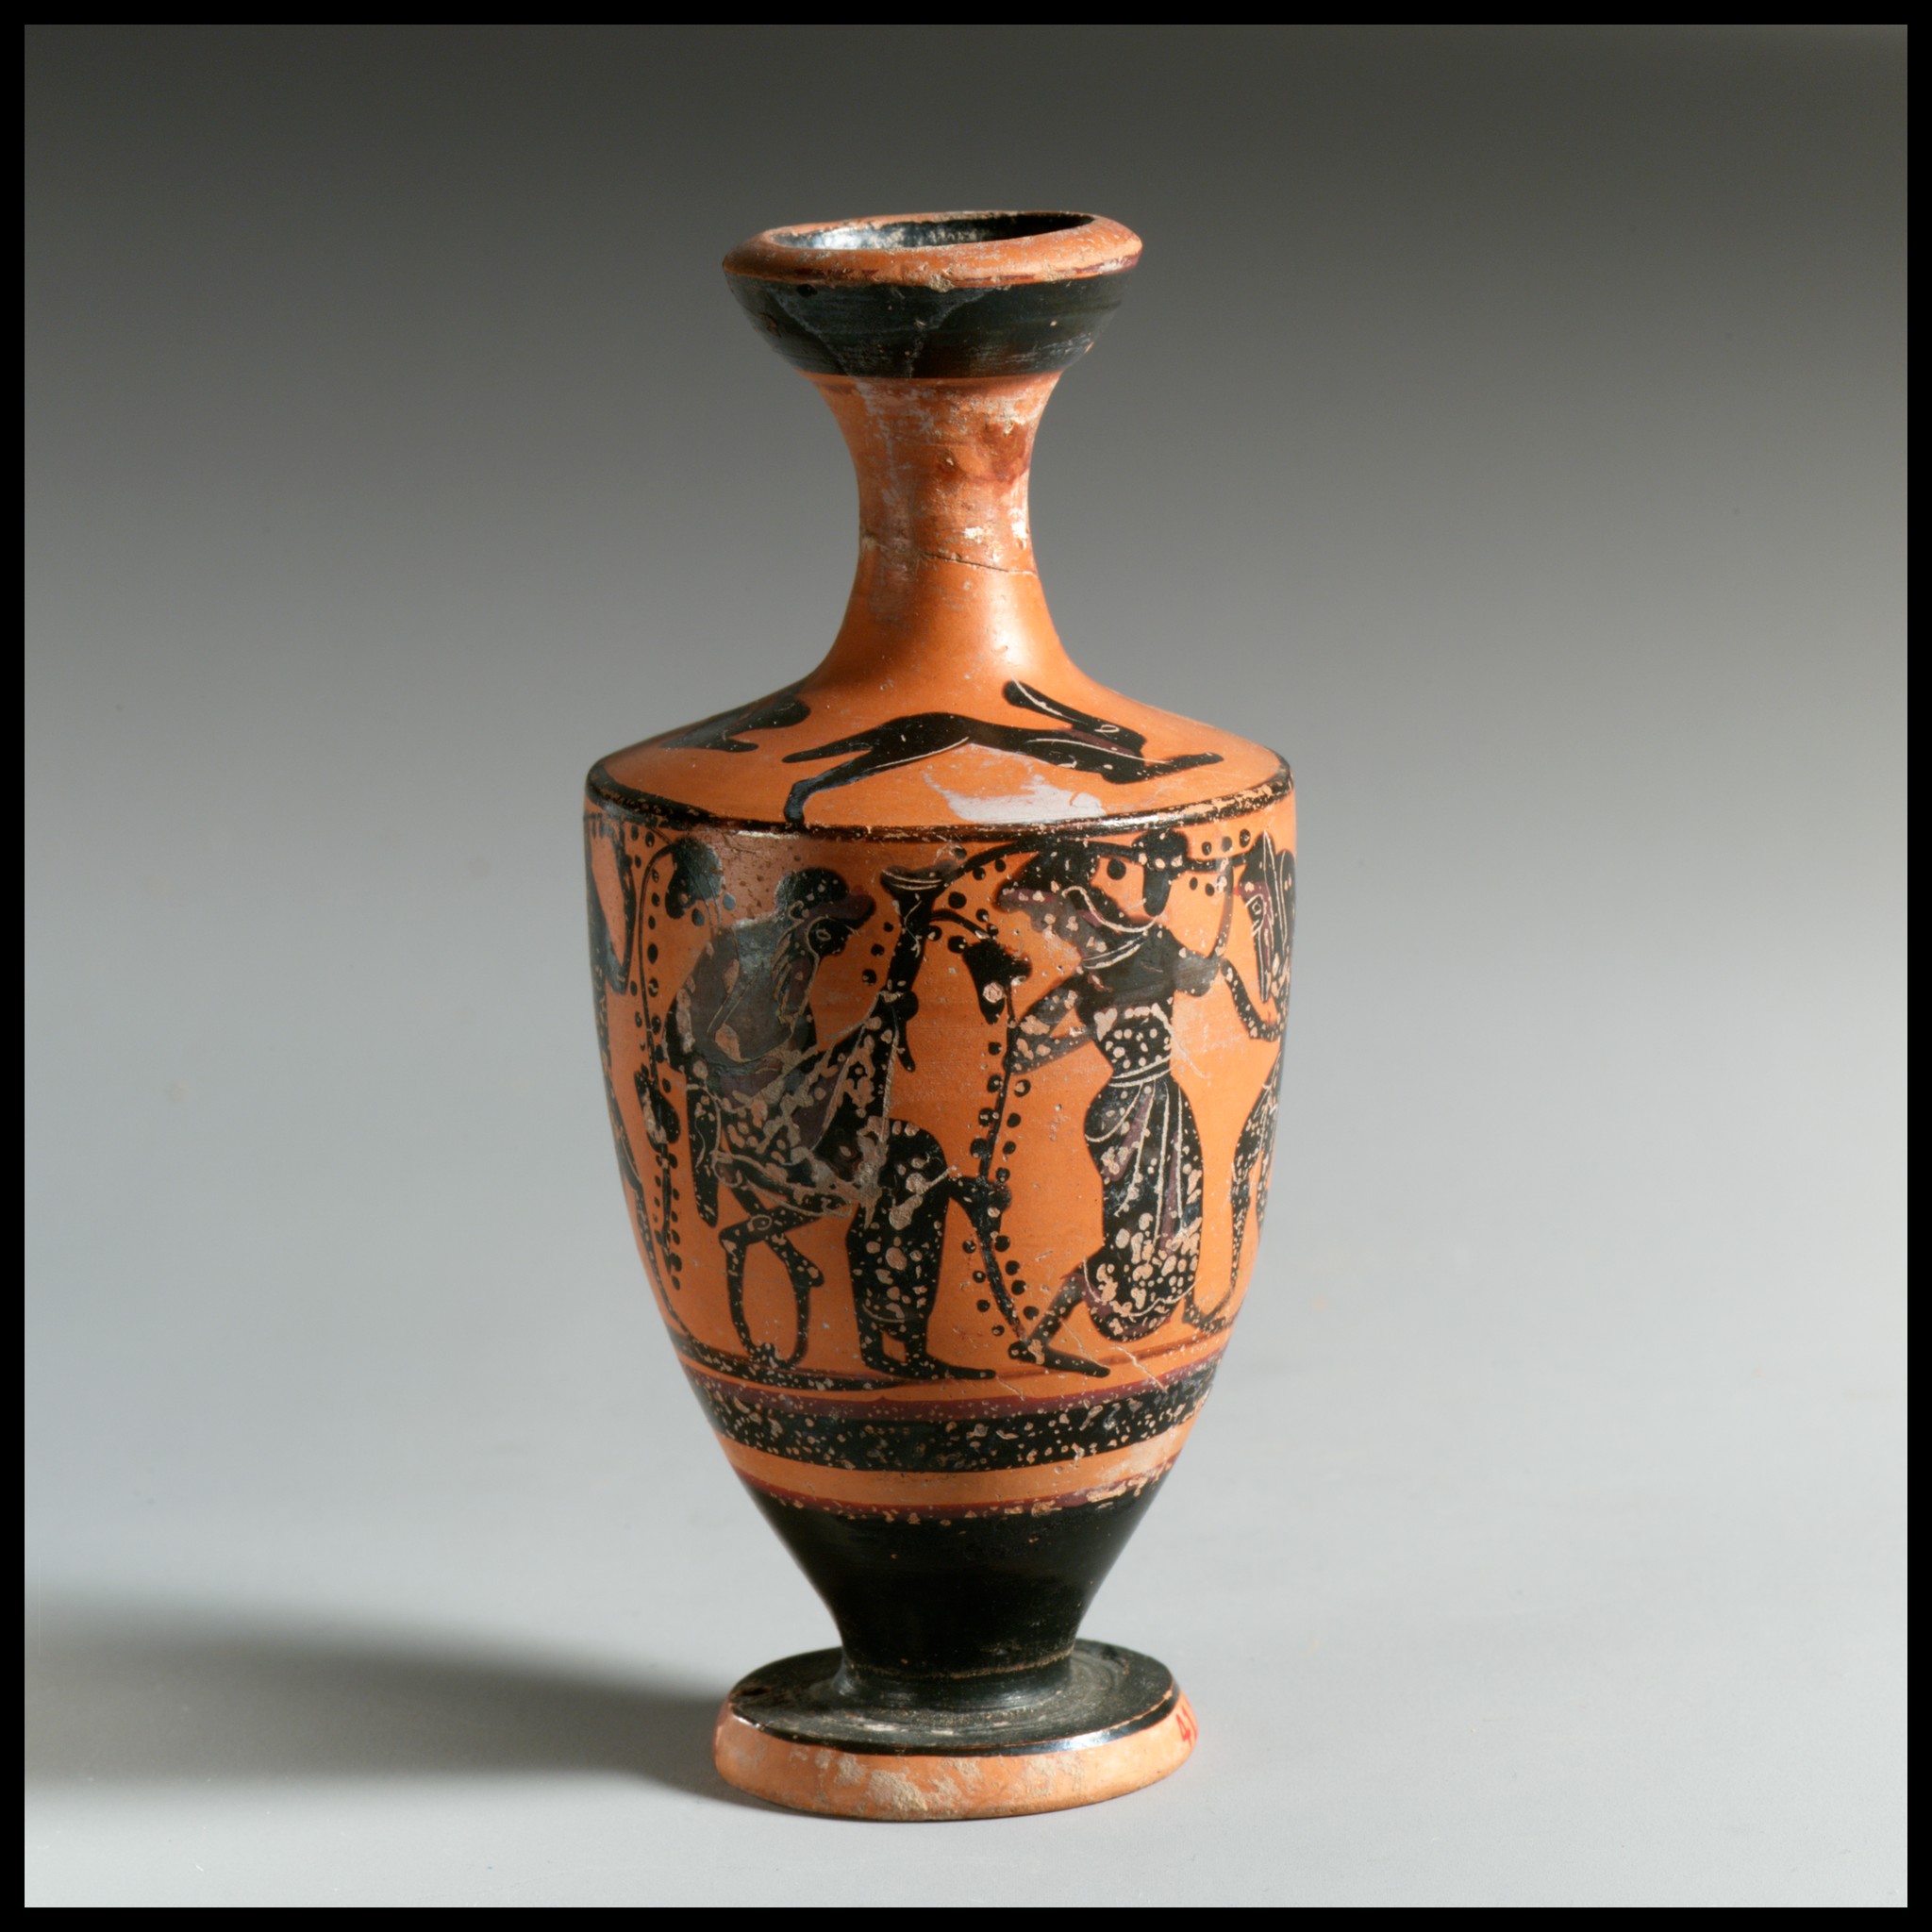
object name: lekythos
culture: greek, attic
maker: class of athens 581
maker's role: artist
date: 500-468 BCE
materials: terracotta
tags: musical instruments,dionysus,silenus,maenads,rabbits